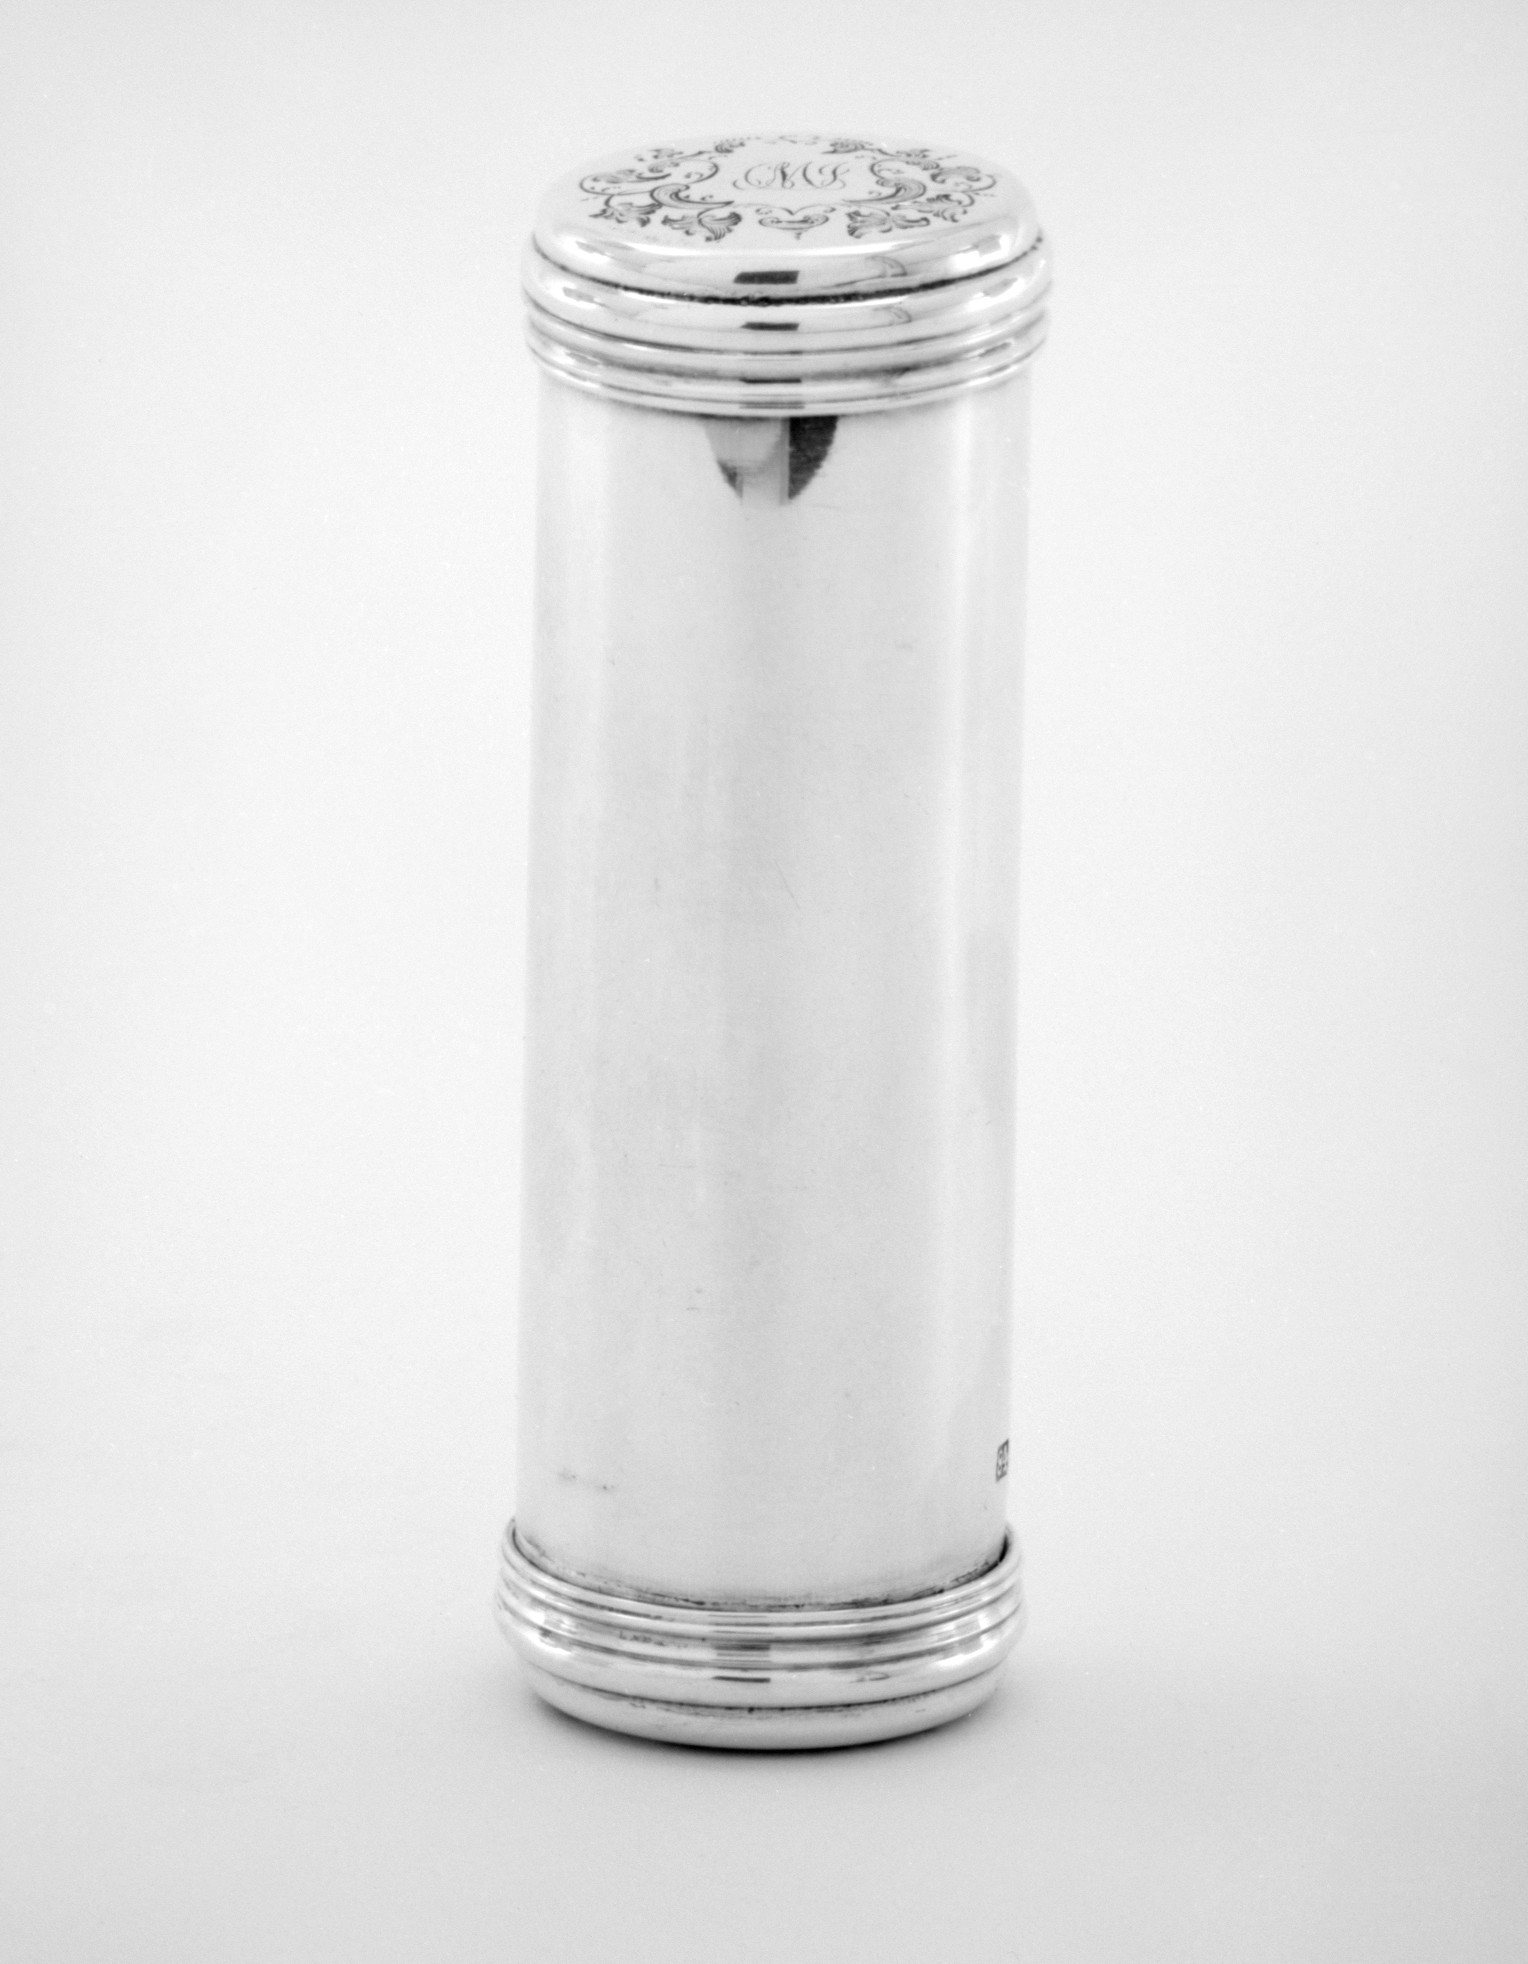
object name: shaving stick soap tube with cover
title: Tube for shaving-stick soap with cover (part of a set)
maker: johann bernhard hertz (hentz)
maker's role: maker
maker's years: 1834-1855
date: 1848-1849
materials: silver